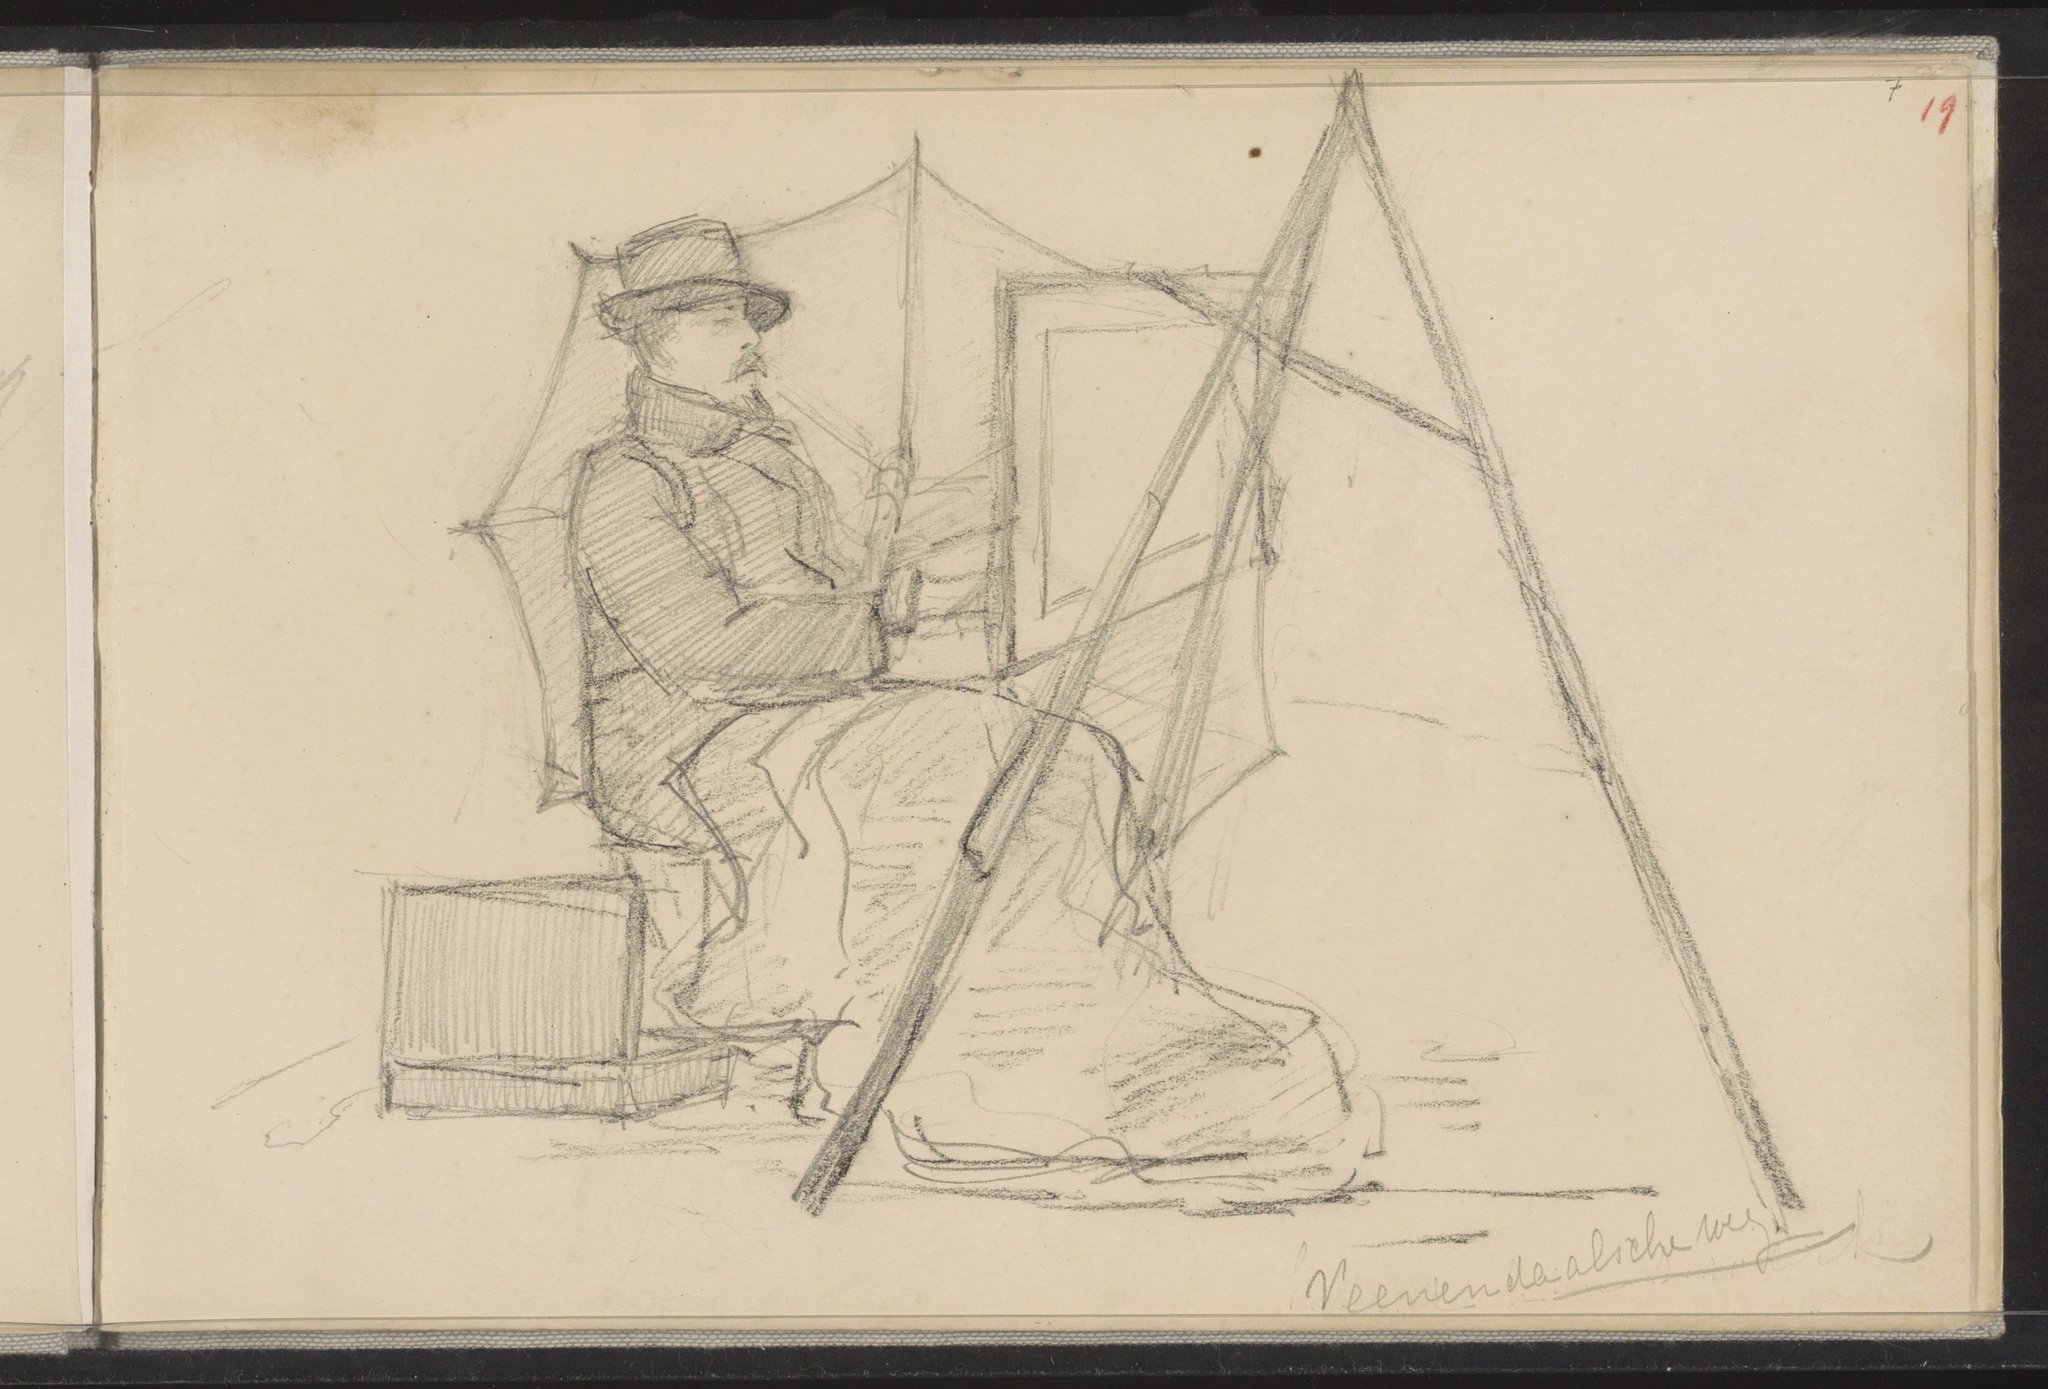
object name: sketchbook leaf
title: Kunstenaar die in de open lucht werkt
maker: jozef israëls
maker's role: draughtsman, painter, print maker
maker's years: 1824-1911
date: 1834-1911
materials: chalk, paper, pencil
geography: veenendaal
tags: painter at work, in his studio - cc - out of doors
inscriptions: annotation: ‘Veenendaalsche weg’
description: De man zit achter een ezel met een deken over zijn schoot. Achter hem staat een paraplu opengeslagen om hem tegen wind te beschermen. De man draagt een hoge hoed en jas. Blad 7 recto uit een schetsboek met 30 bladen.